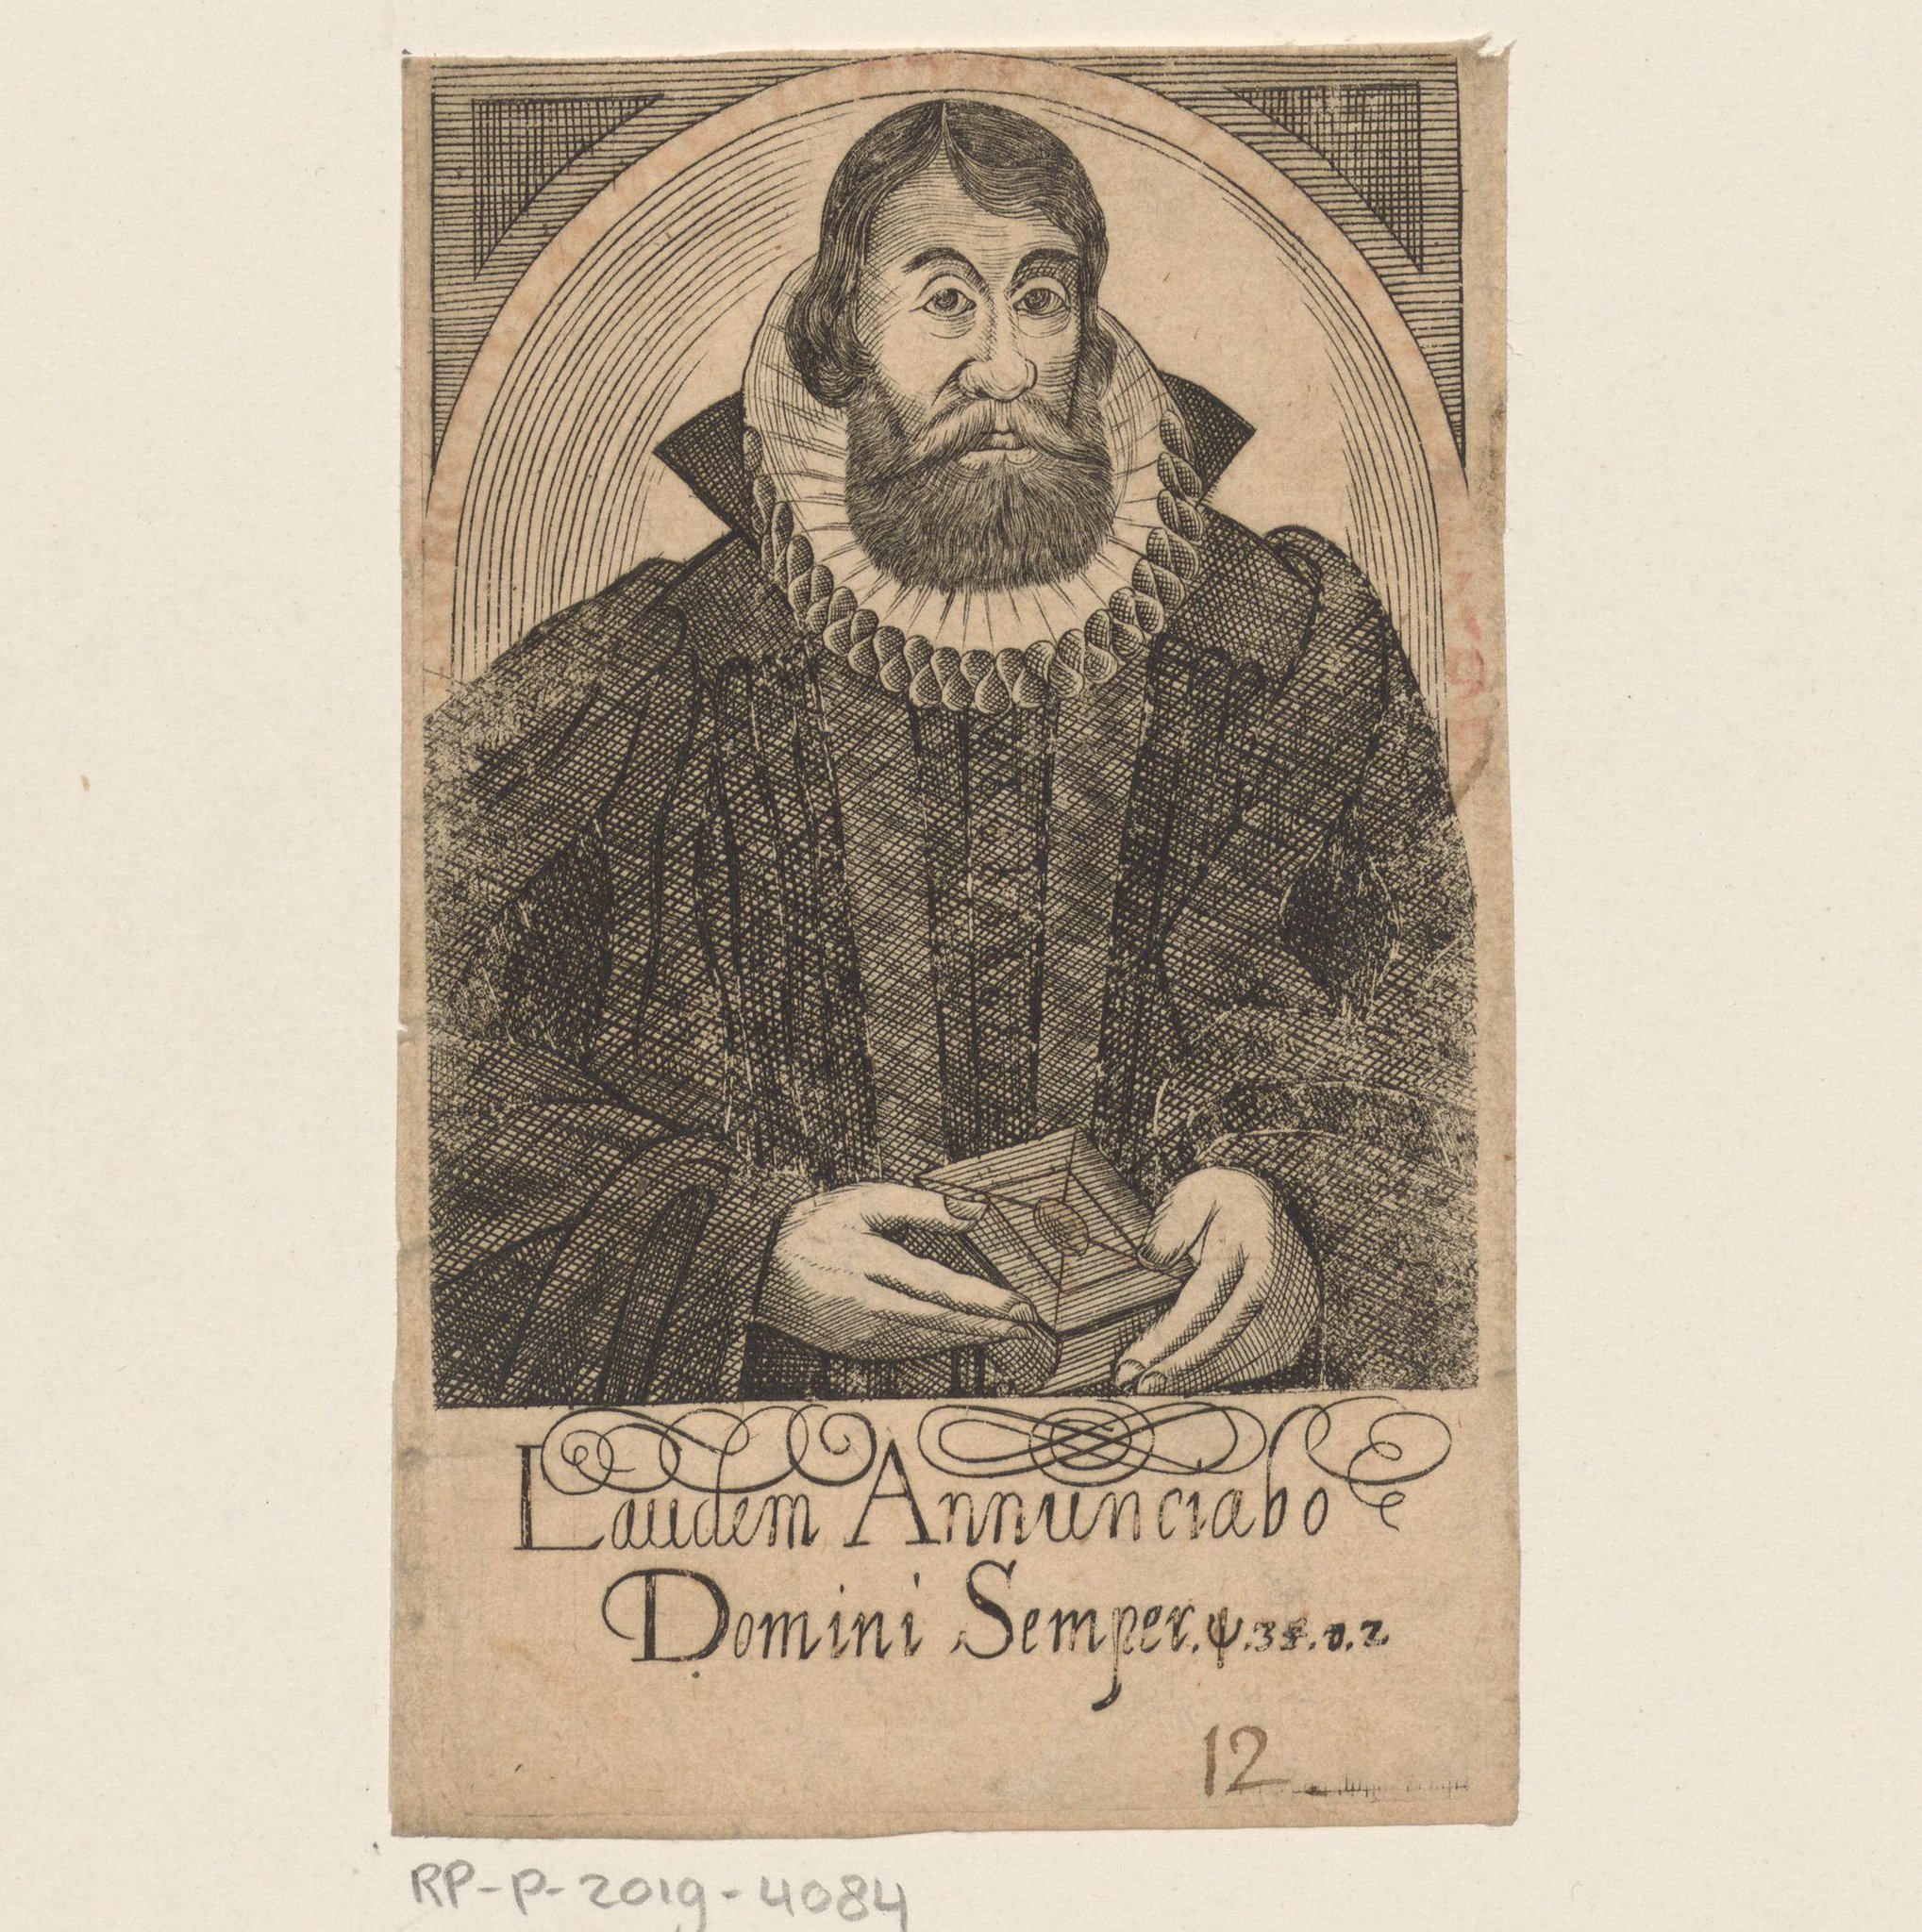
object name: print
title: Portret van Friedrich Balduin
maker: Anonymous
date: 1600-1699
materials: paper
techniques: engraving, etching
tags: theologian, historical persons, book